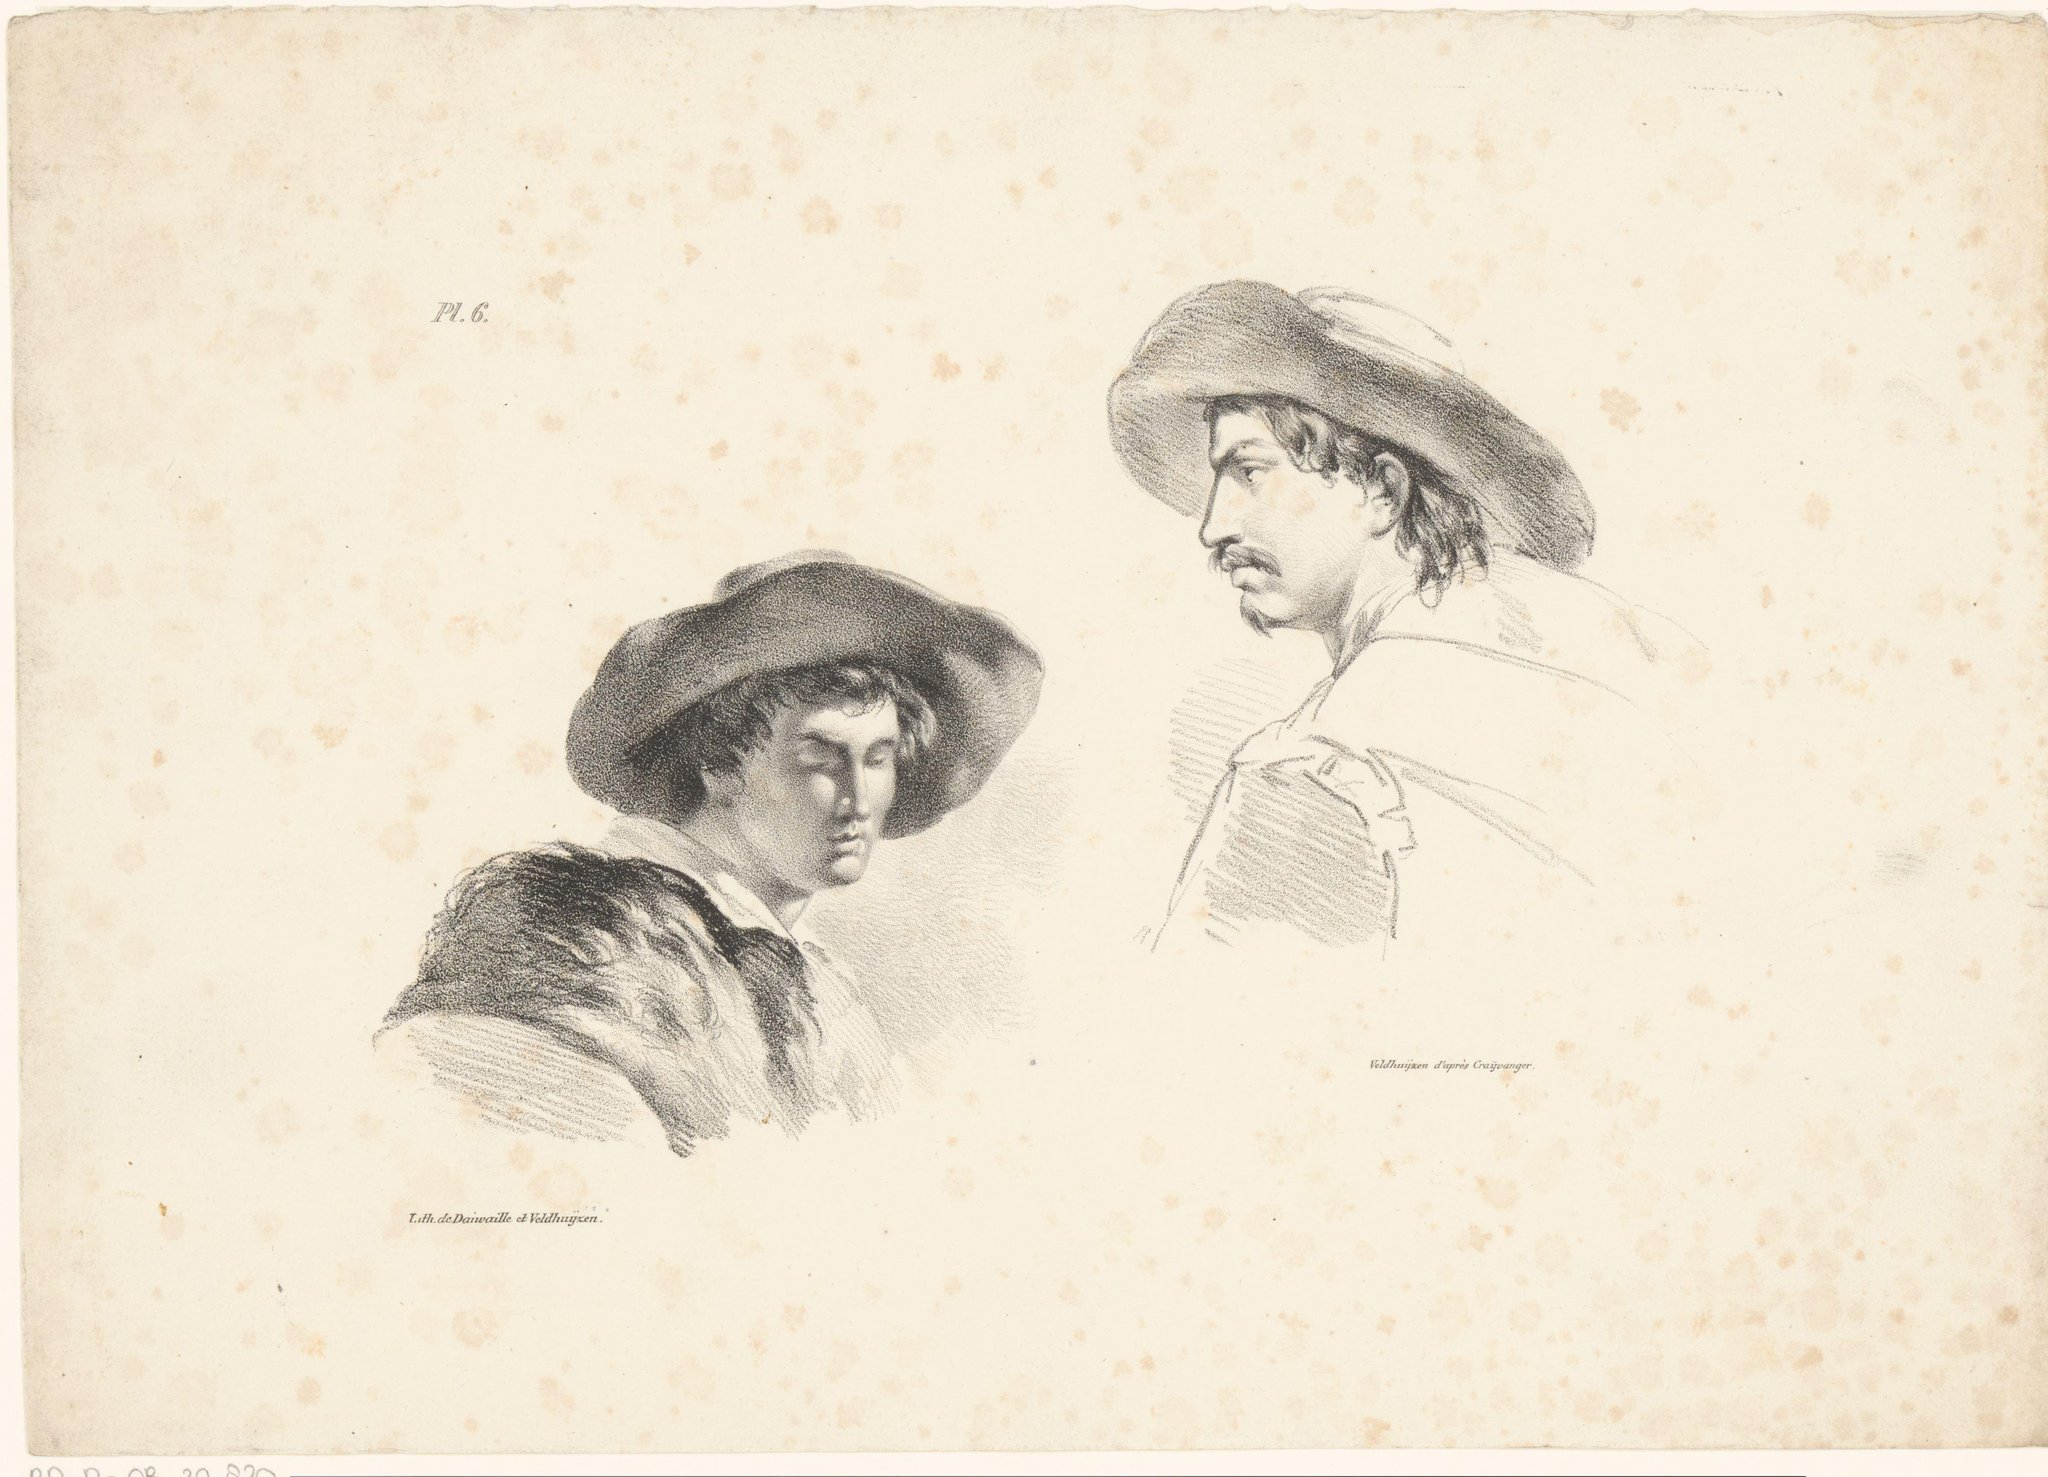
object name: print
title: Mannen met hoed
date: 1831-1832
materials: paper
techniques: lithograph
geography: netherlands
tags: adult man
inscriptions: collector's mark: Lugt 2228